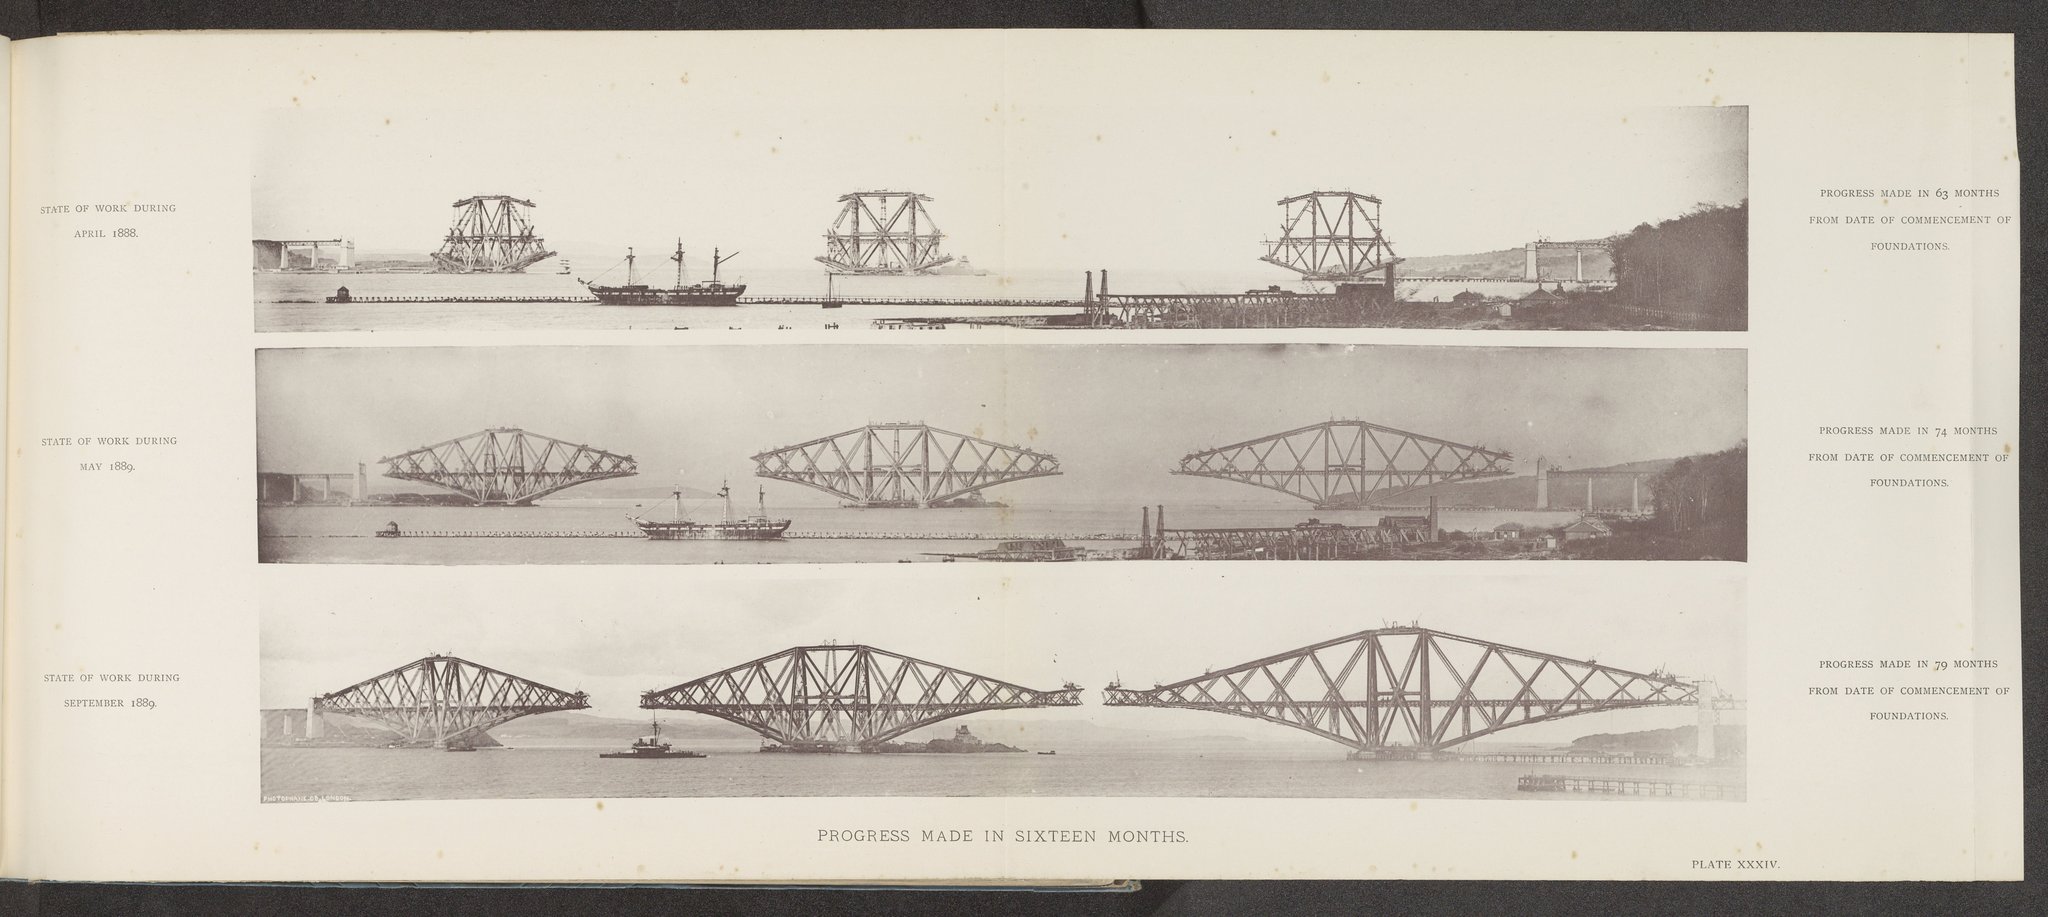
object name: page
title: Progress made in sixteen months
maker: Anonymous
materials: paper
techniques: photograph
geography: united kingdom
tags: building materials, bridge, building-site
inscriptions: inscription: ‘State of work during 1888. (...) progress made in 79 months from date of commencement of foundations.’, number: ‘Plate XXXIV.’